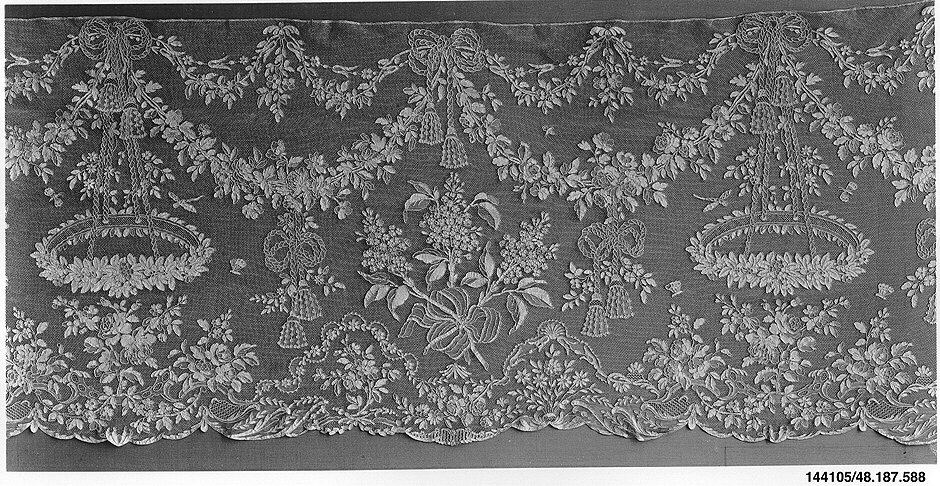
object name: flounce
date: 1801-1833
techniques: lace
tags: flowers